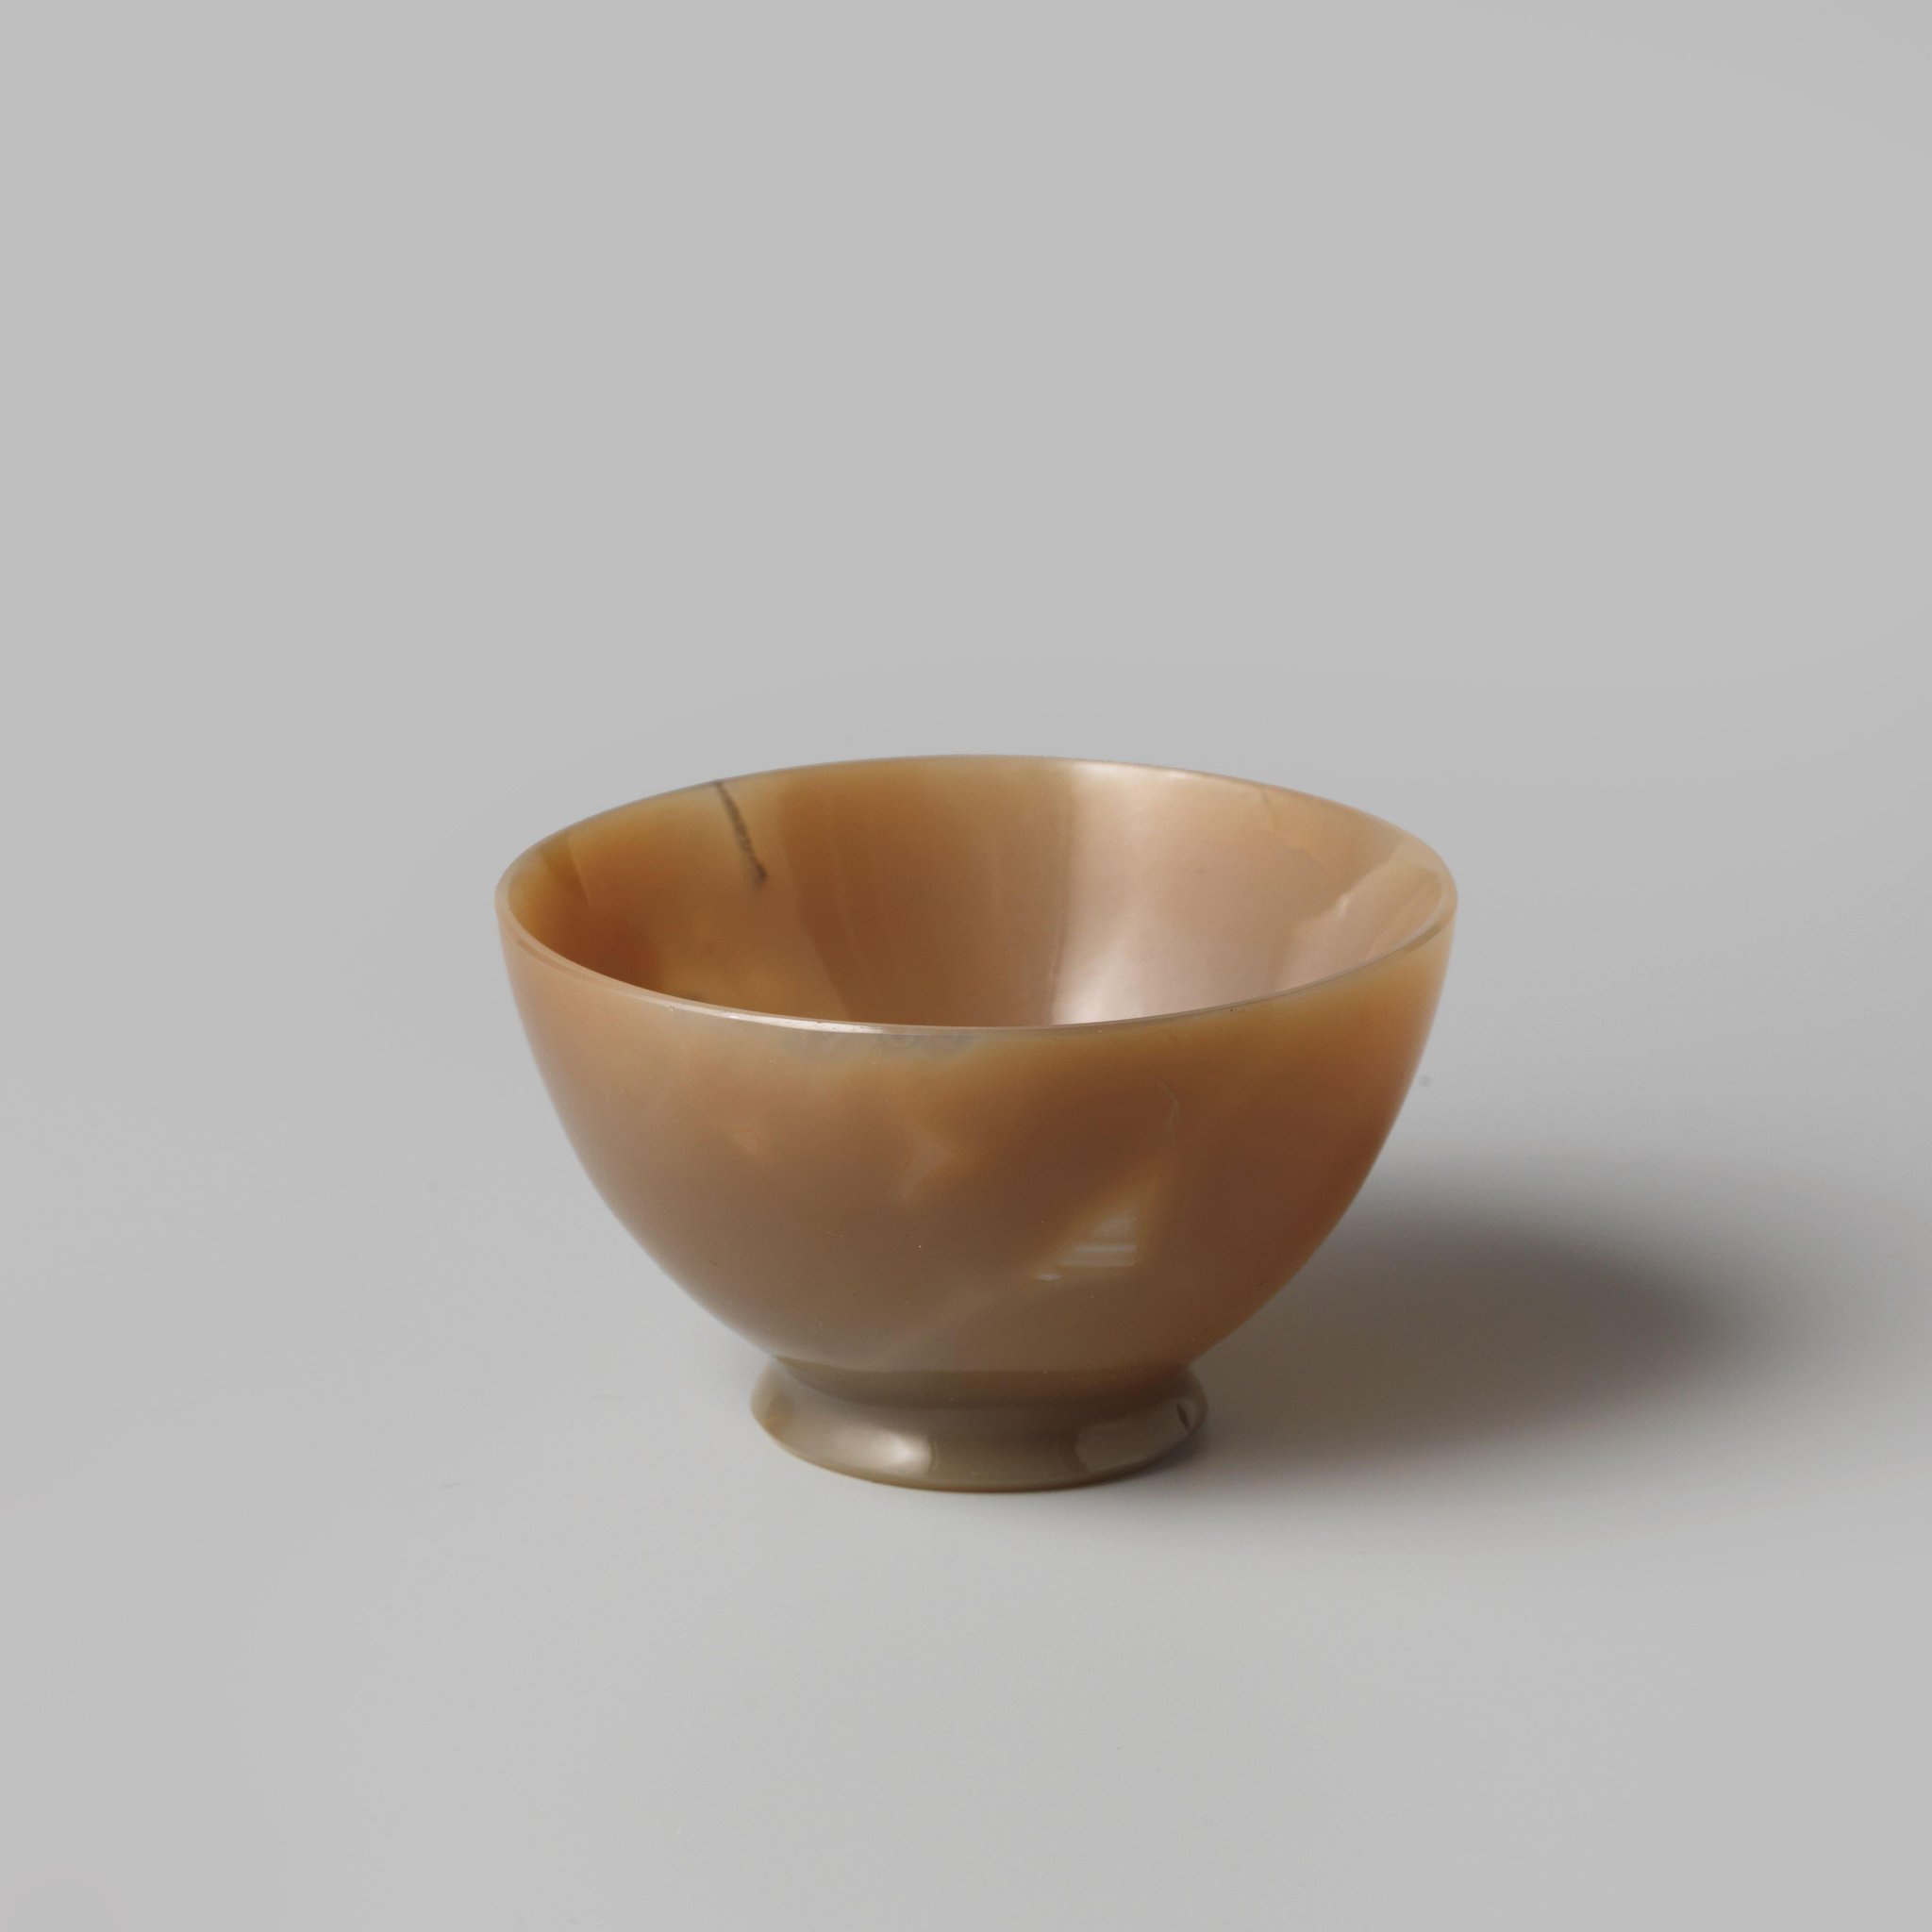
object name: cup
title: Kop van grijze agaat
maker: Anonymous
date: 1600-1699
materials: stone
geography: netherlands